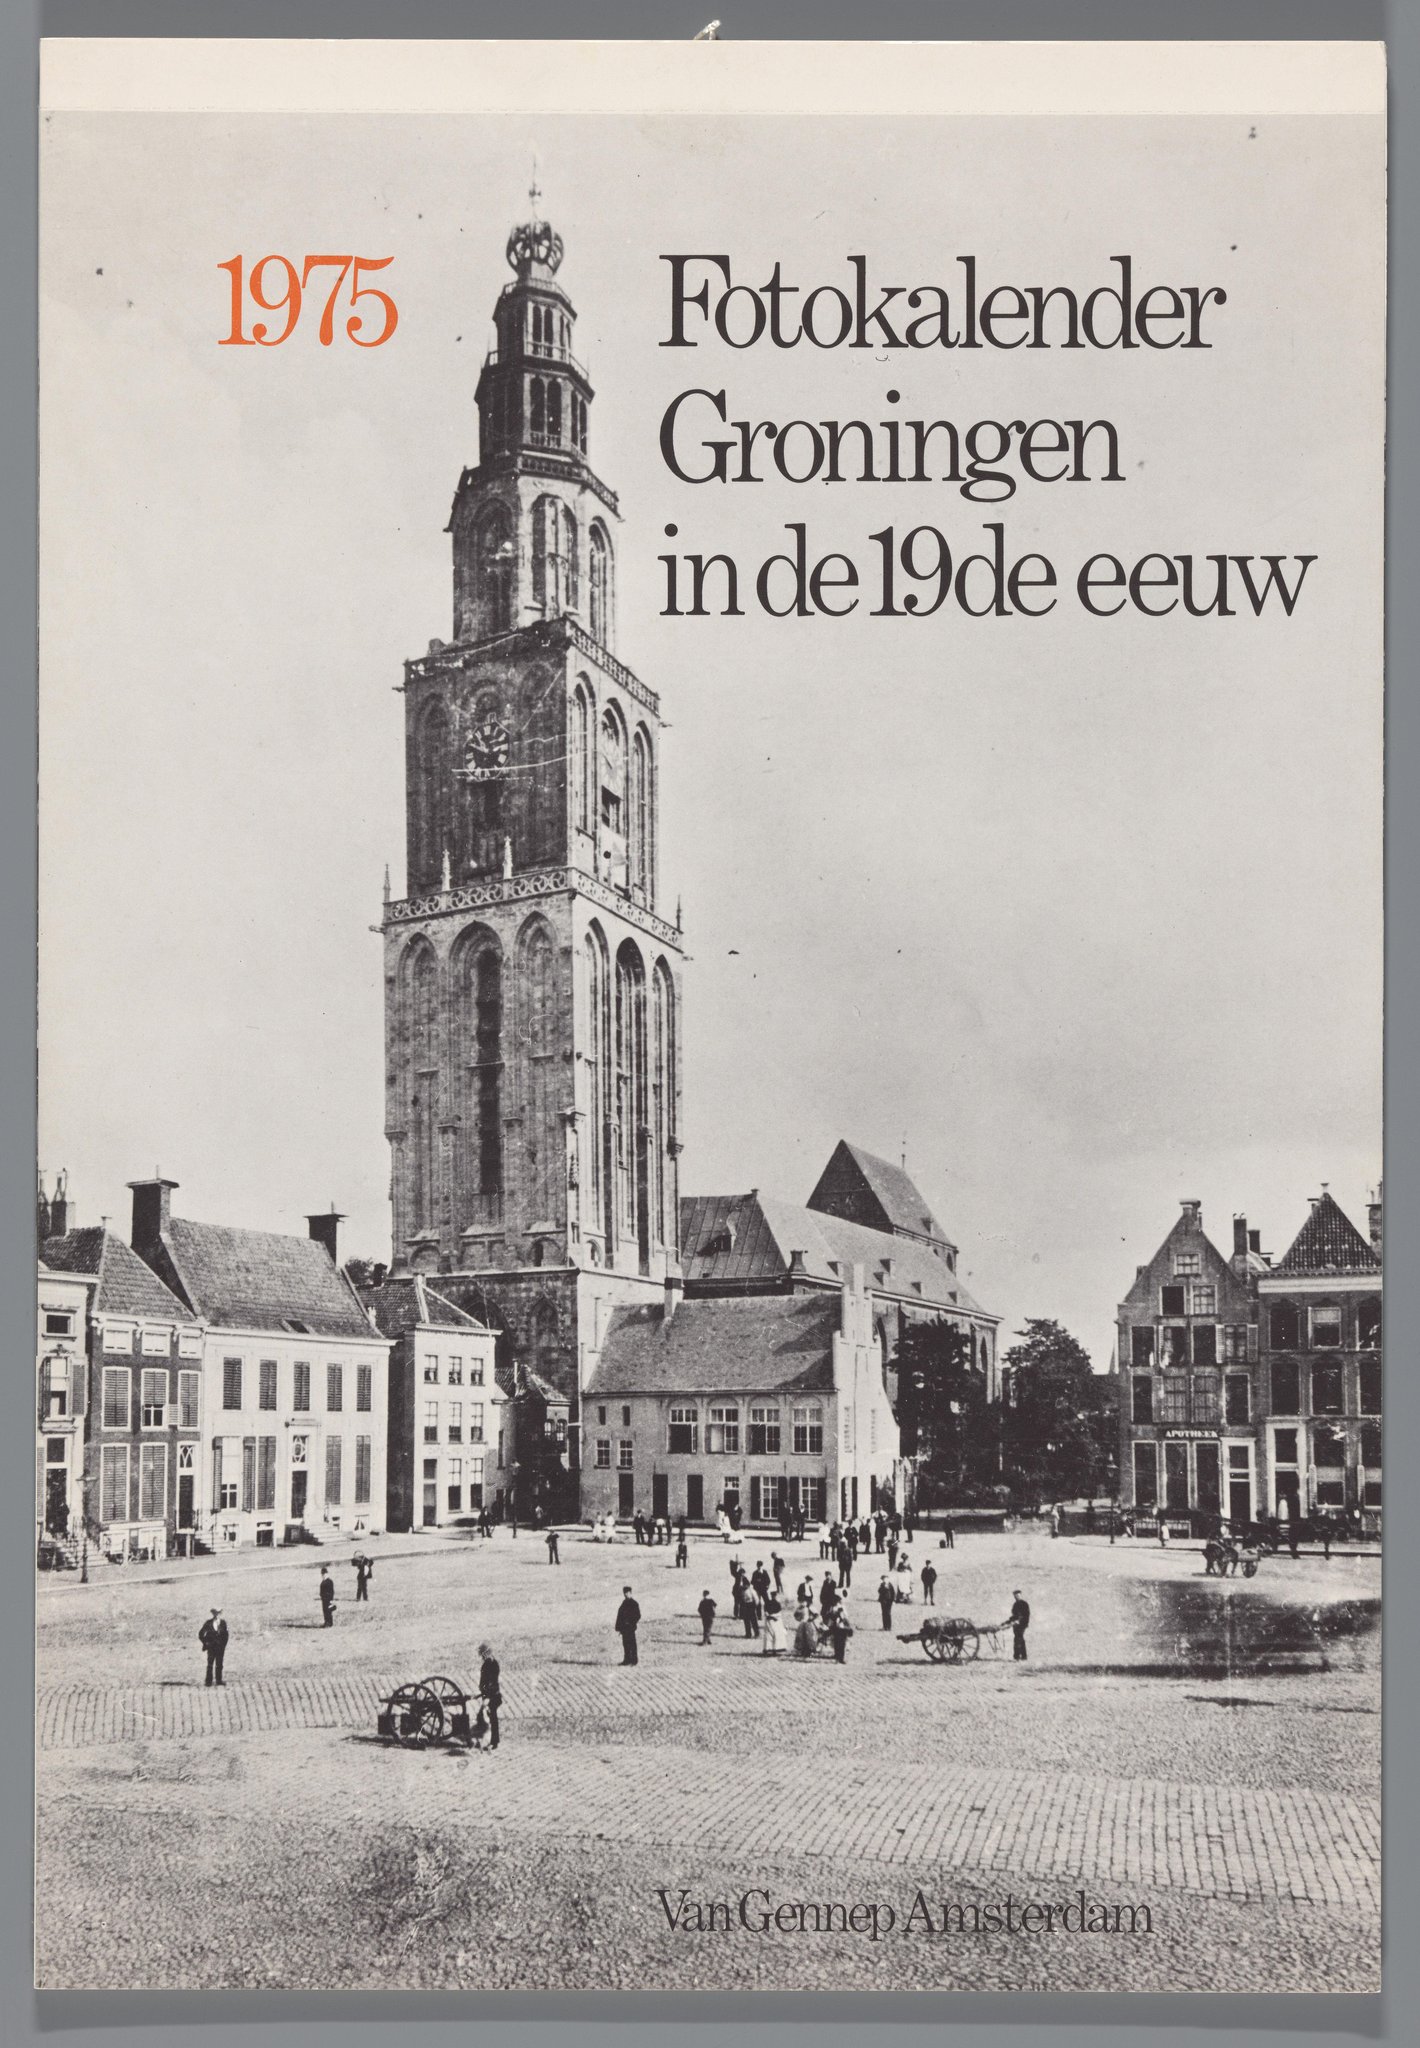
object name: photomechanical print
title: Groningen in de 19de eeuw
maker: Anonymous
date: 1975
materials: paper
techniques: offset printed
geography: groningen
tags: city-view in general; 'veduta'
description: Kalender voor het jaar 1975 met 13 fotomechanische afdrukken van stadsgezichten uit Groningen, allen afkomstig uit de fotocollectie van het gemeentearchief Groningen.